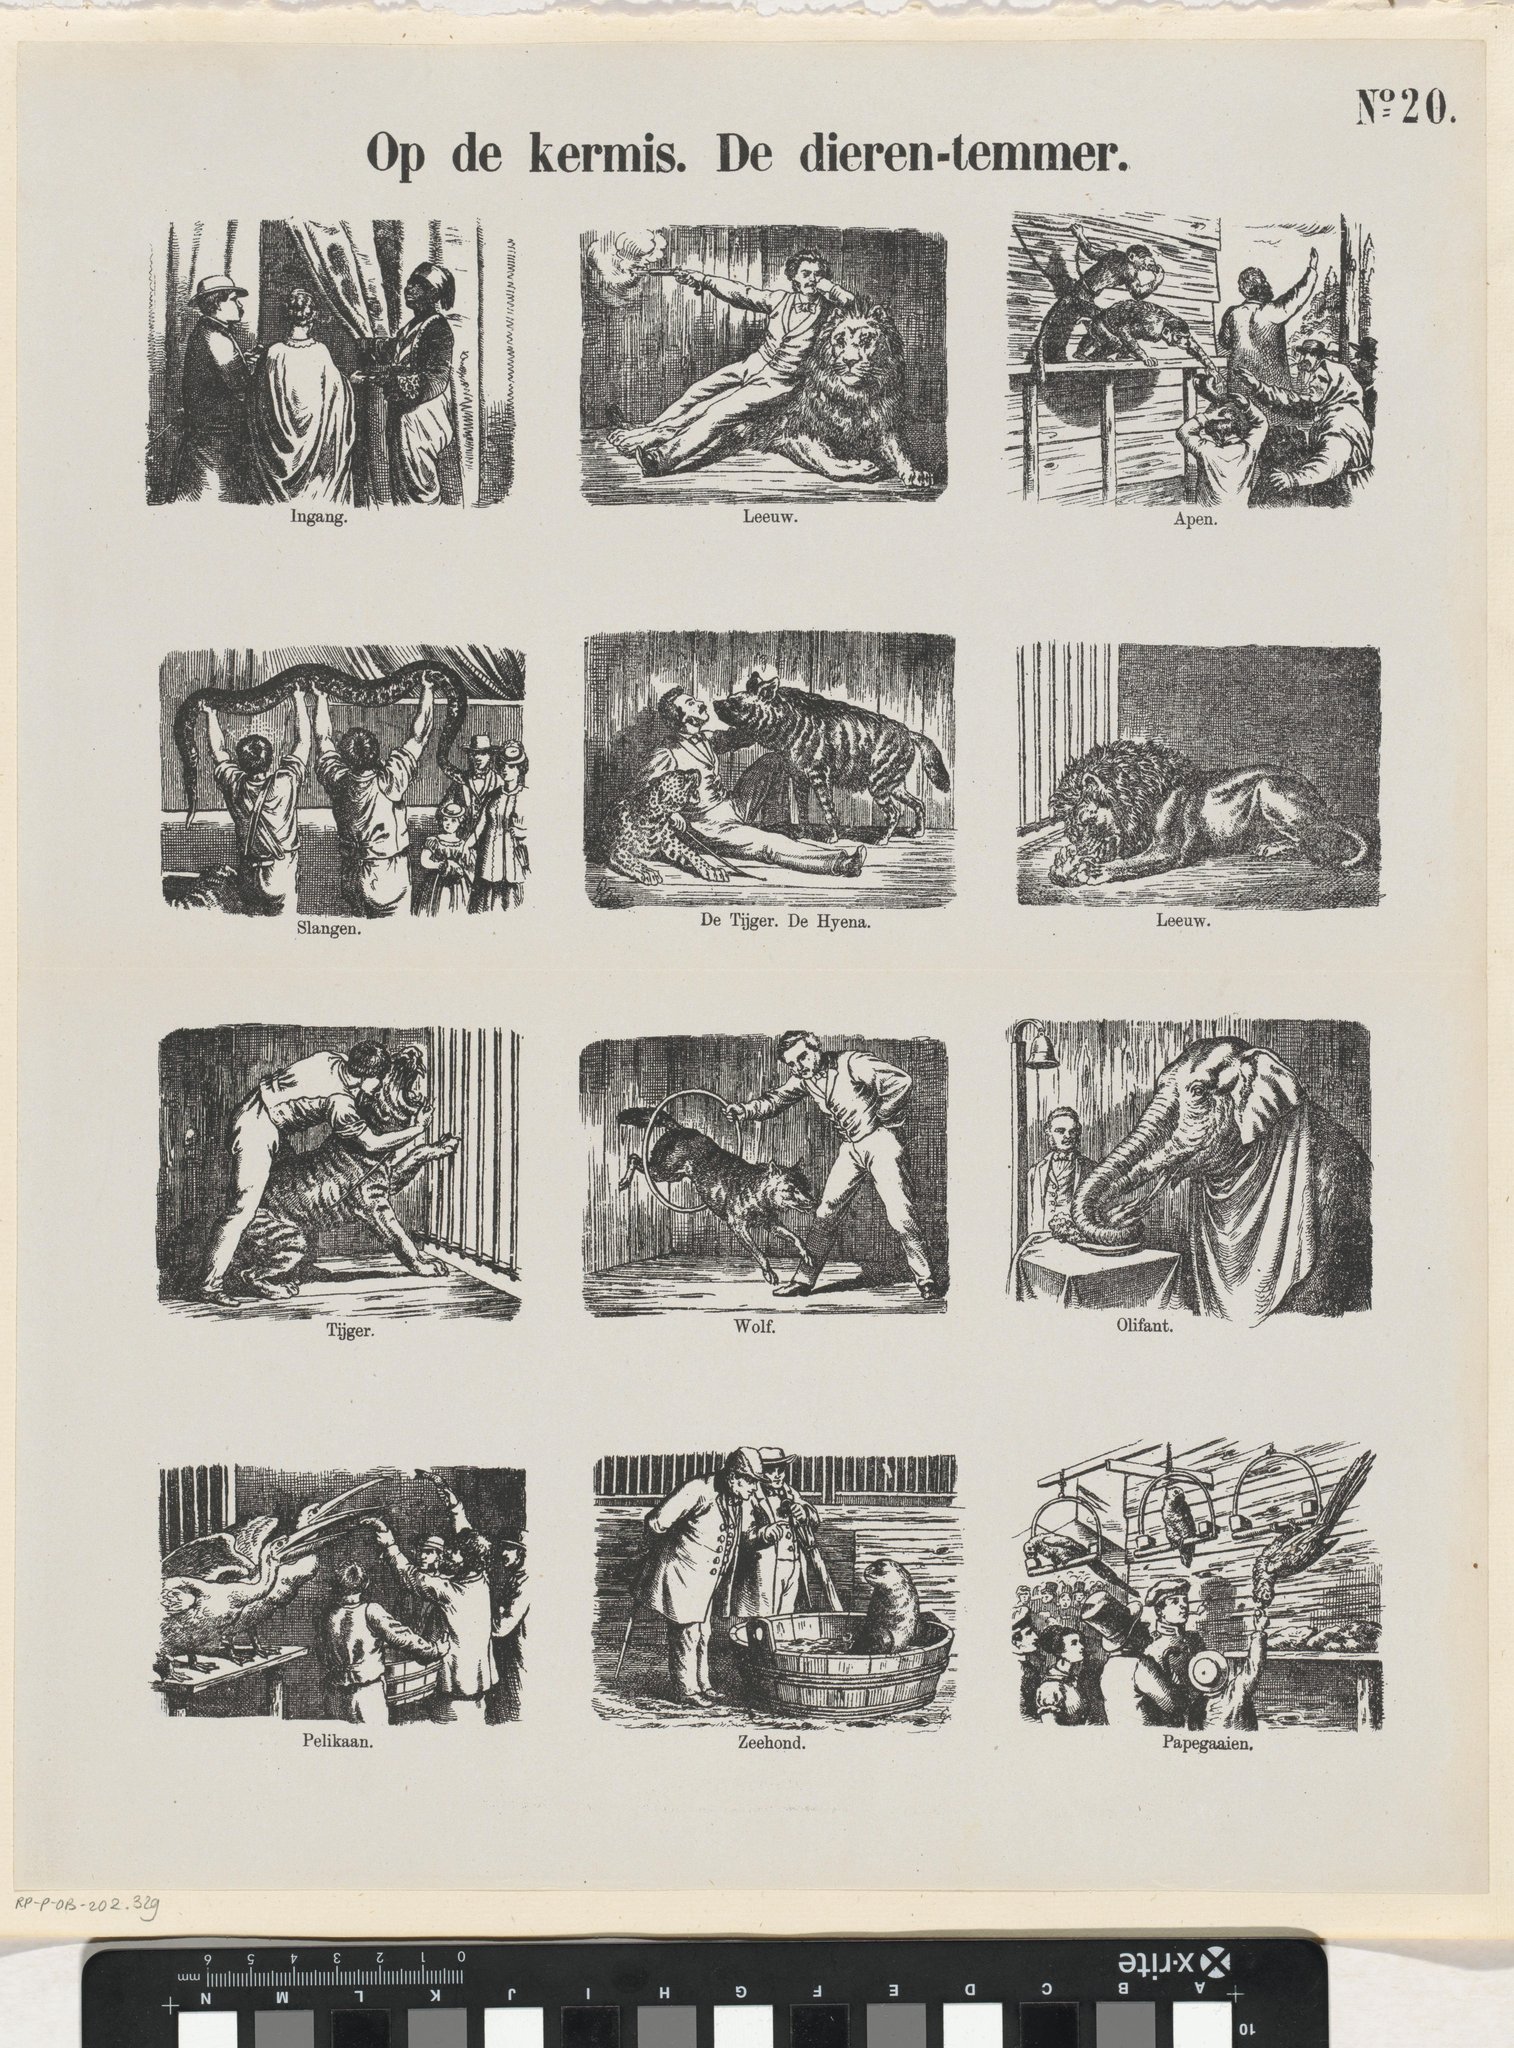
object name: print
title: Op de kermis / De dieren-temmer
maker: Anonymous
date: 1873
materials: paper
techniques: letterpress printing, lithograph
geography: amsterdam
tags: taming and training of animals, circus animals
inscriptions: collector's mark: Lugt 2760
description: Blad met 12 voorstellingen van circusdieren en hun trainers, waaronder een leeuw, apen, een olifant en een zeehond. Onder elke afbeelding een onderschrift. Genummerd rechtsboven: No. 20.